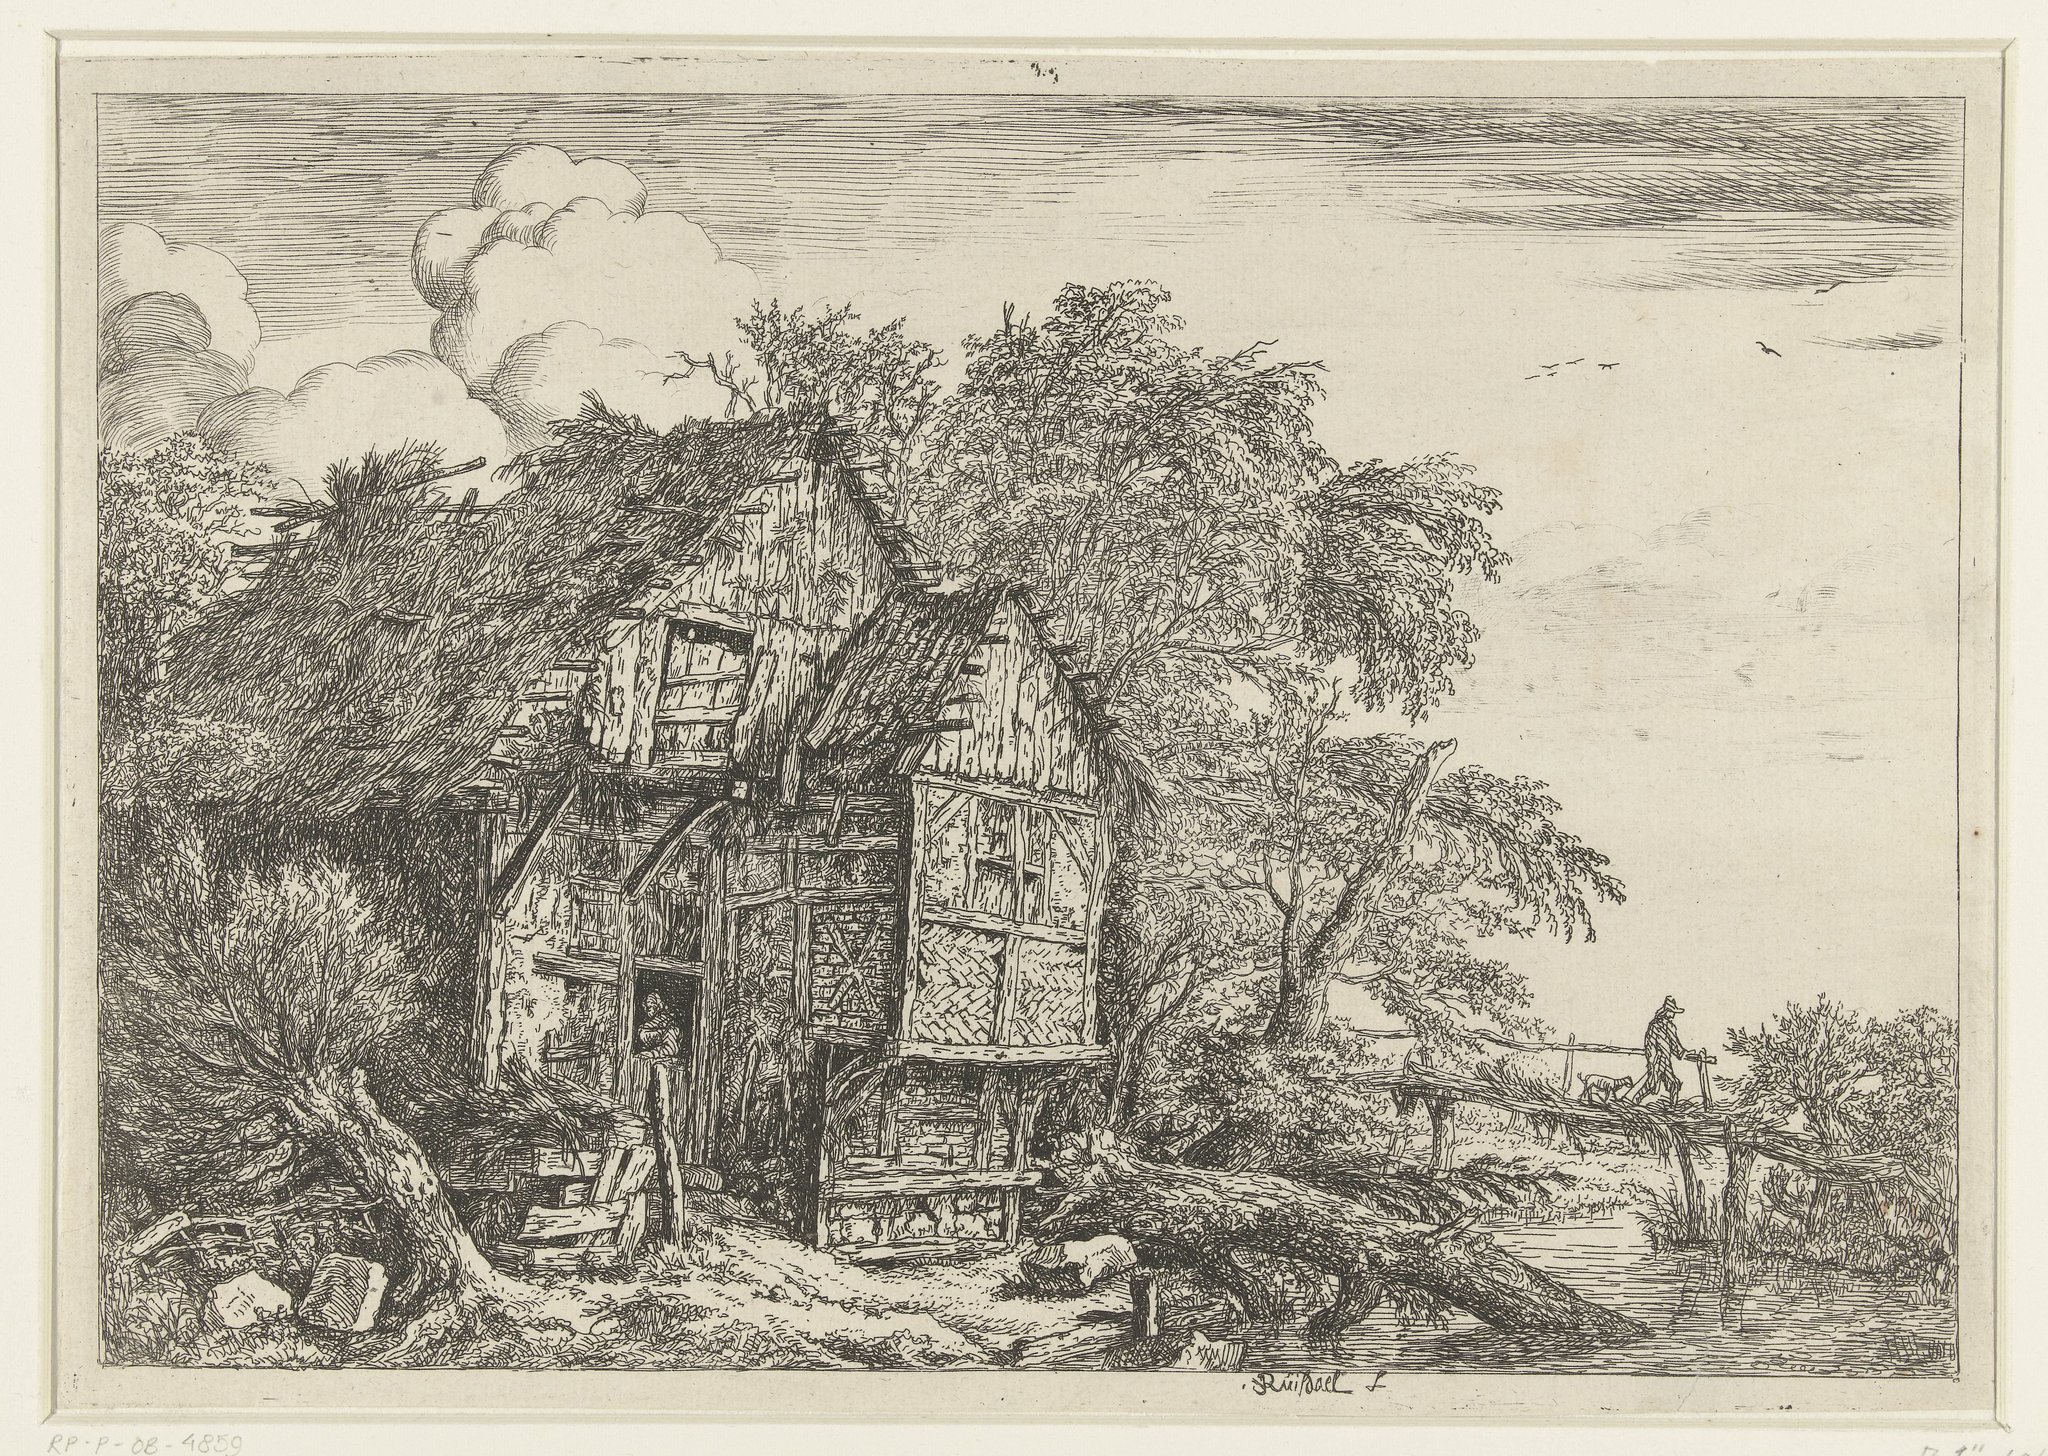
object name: print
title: De kleine brug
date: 1650-1699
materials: paper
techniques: drypoint, etching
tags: cottage, bridge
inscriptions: collector's mark: Lugt 240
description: Volgens Slive (2001) zijn de wolken in de tweede staat mogelijk toegevoegd vóór het einde van de 17e eeuw, zie p. 605.